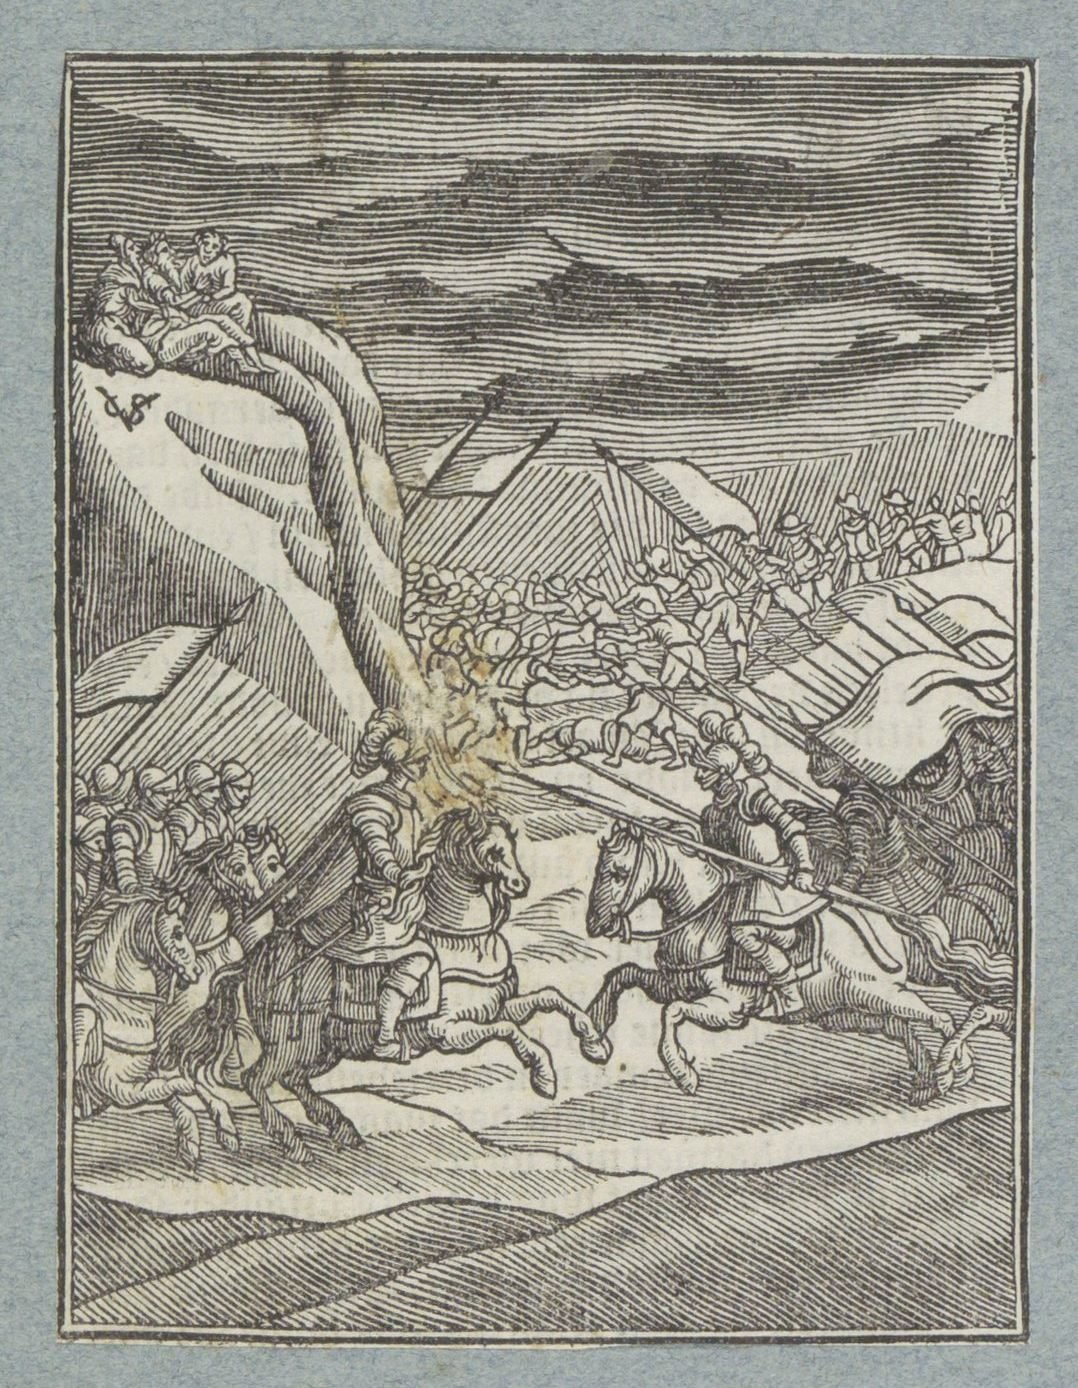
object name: print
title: Oorlog met de Amalekieten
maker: pieter jacobsz. paets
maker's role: publisher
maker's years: 1587-1667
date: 1645-1646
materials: paper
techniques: letterpress printing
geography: amsterdam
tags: moses sitting on a rock, arms held up by aaron and hur; the amalekites are defeated, the amalekites come to war against the israelites (exodus 17:8-16)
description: In de woestijn bevochten de Israëlieten de stam van Amalek. Links op een heuvel Mozes, Aäron en Hur. Zolang Mozes zijn armen omhooghield, hadden de Israëlieten de overhand, maar zodra hij ze liet zakken, werden ze achteruitgedreven. Toen Mozes vermoeid raakte, lieten Aäron en Hur hem op een steen zitten en ondersteunden zij zijn armen tot het einde van de dag, toen Amalek verslagen was. De prent maakt deel uit van een album.